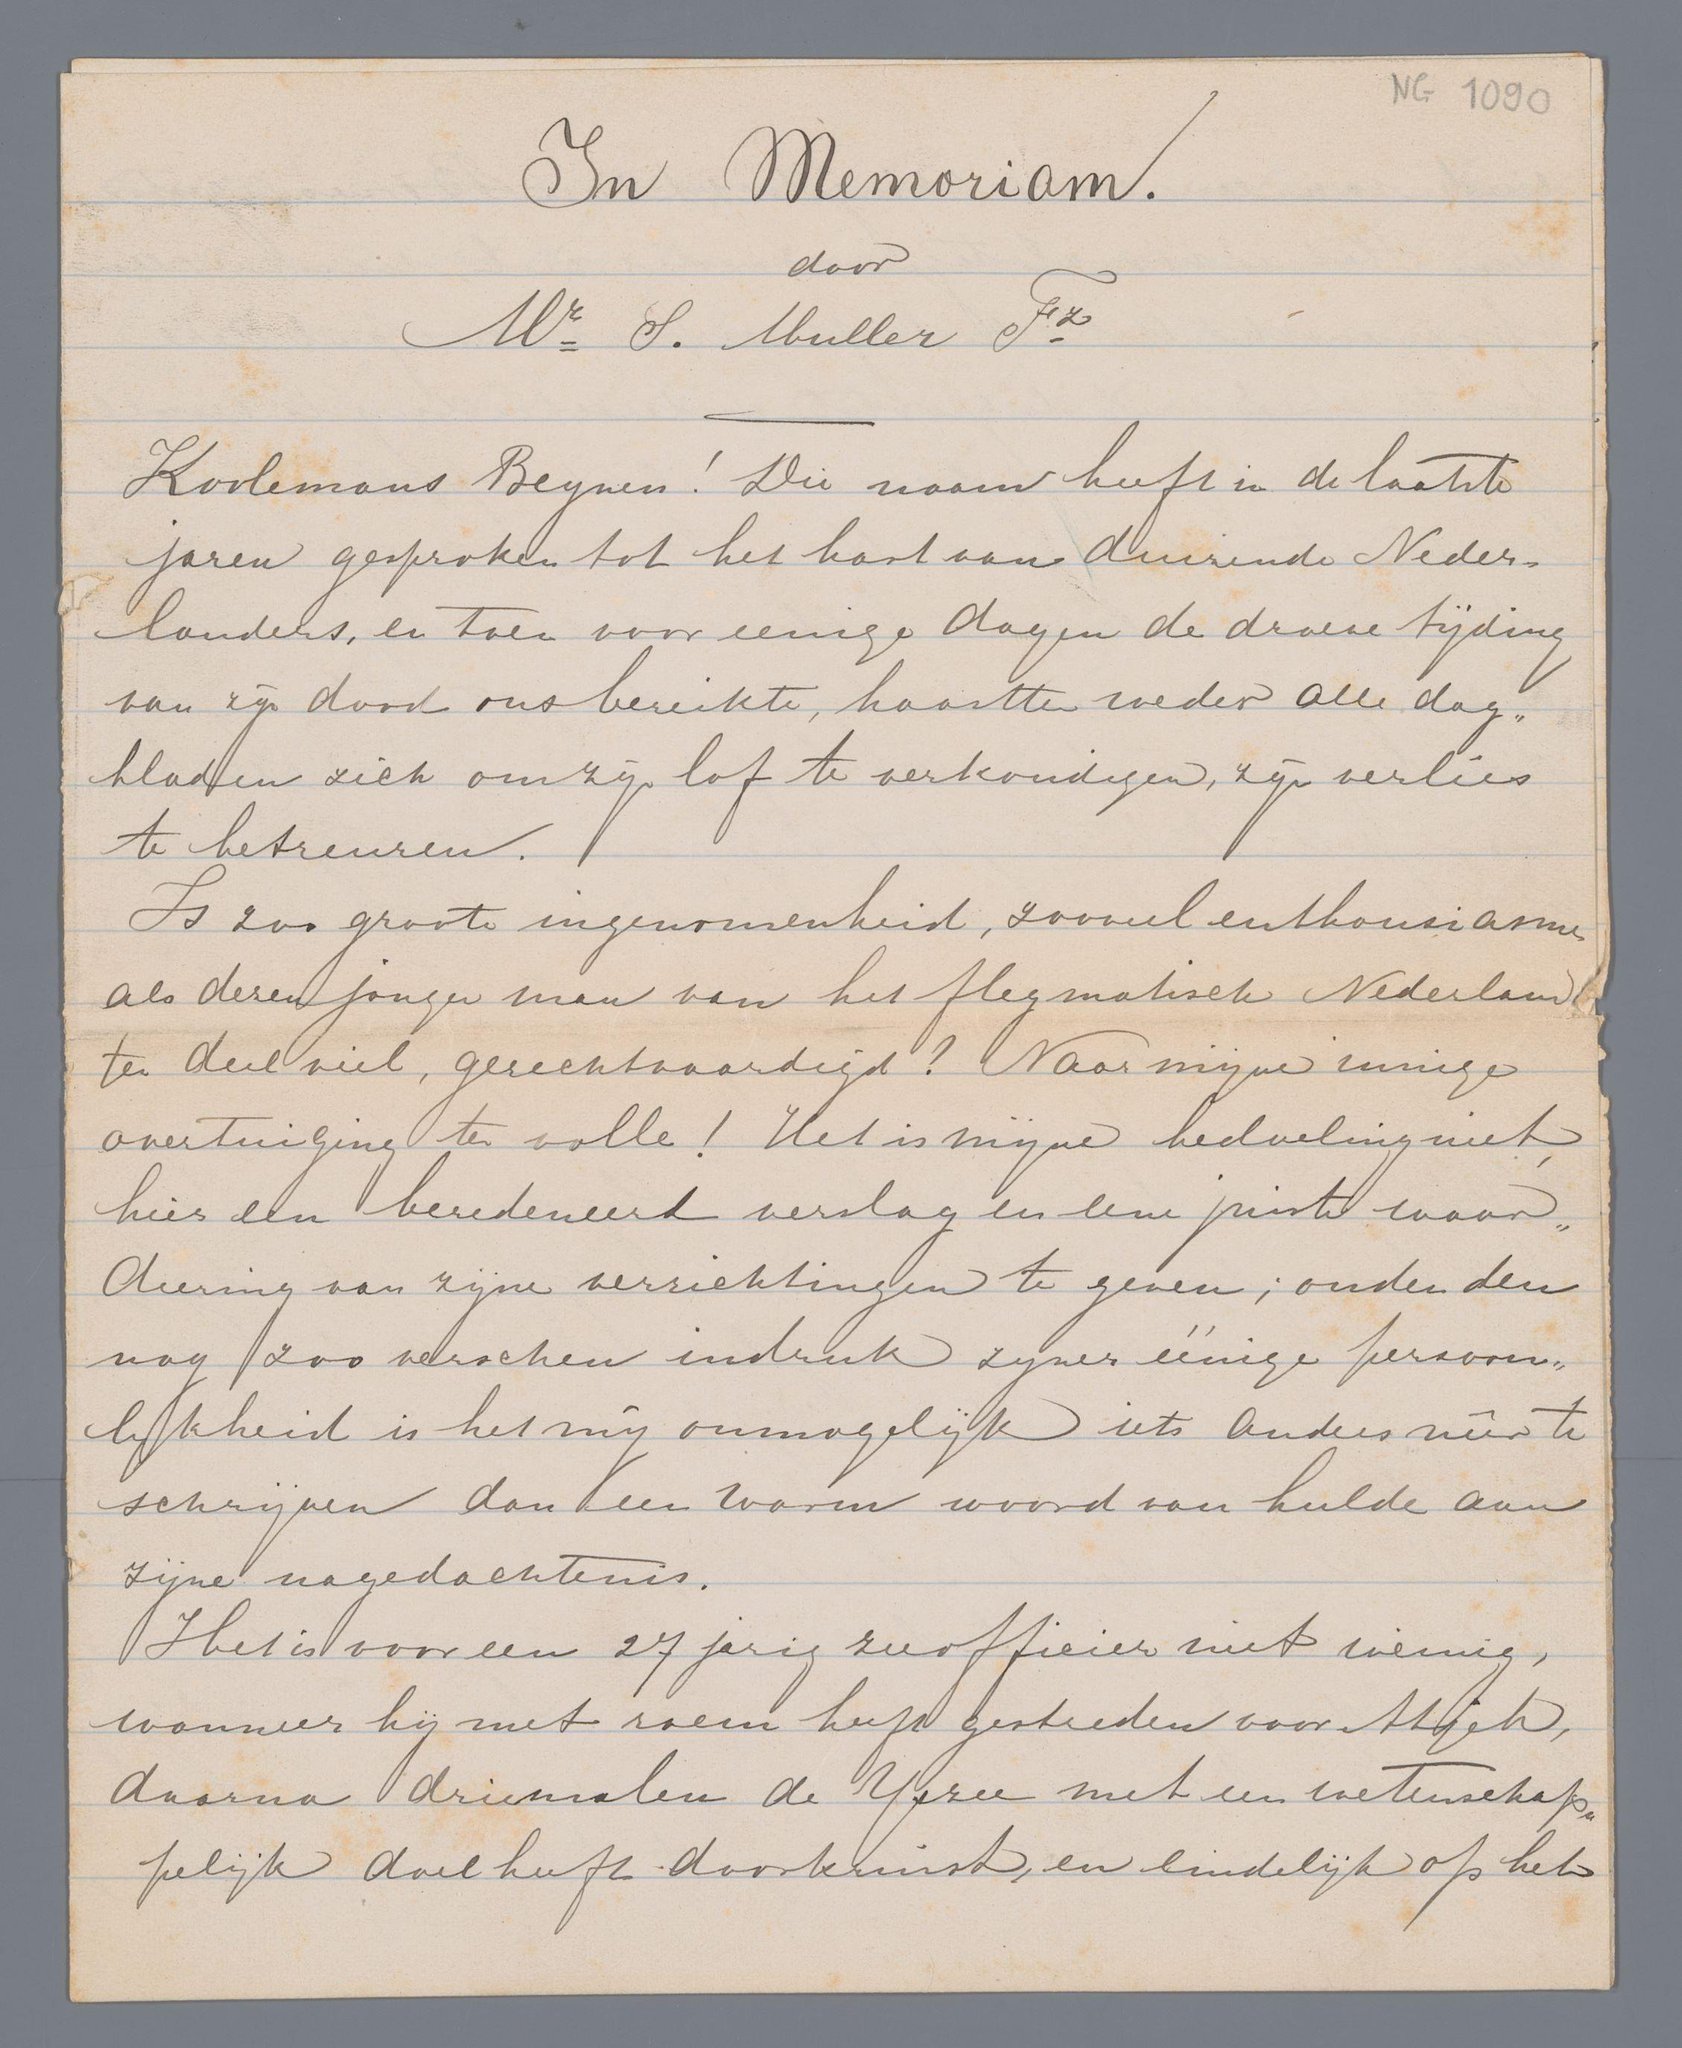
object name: document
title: In Memoriam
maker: samuel muller (1848-1922)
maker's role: rijksarchivaris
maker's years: 1848-1922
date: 1879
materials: ink, paper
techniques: writing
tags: l.r. koolemans beynen, nova zembla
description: Handschrift op zes pp (een dubbelgevouwen vel en een enkel vel papier), in grijze inkt (eigen handschrift van Mr S. Muller Fz?), over de tè jong gestorven marineman Koolemans Beynen.